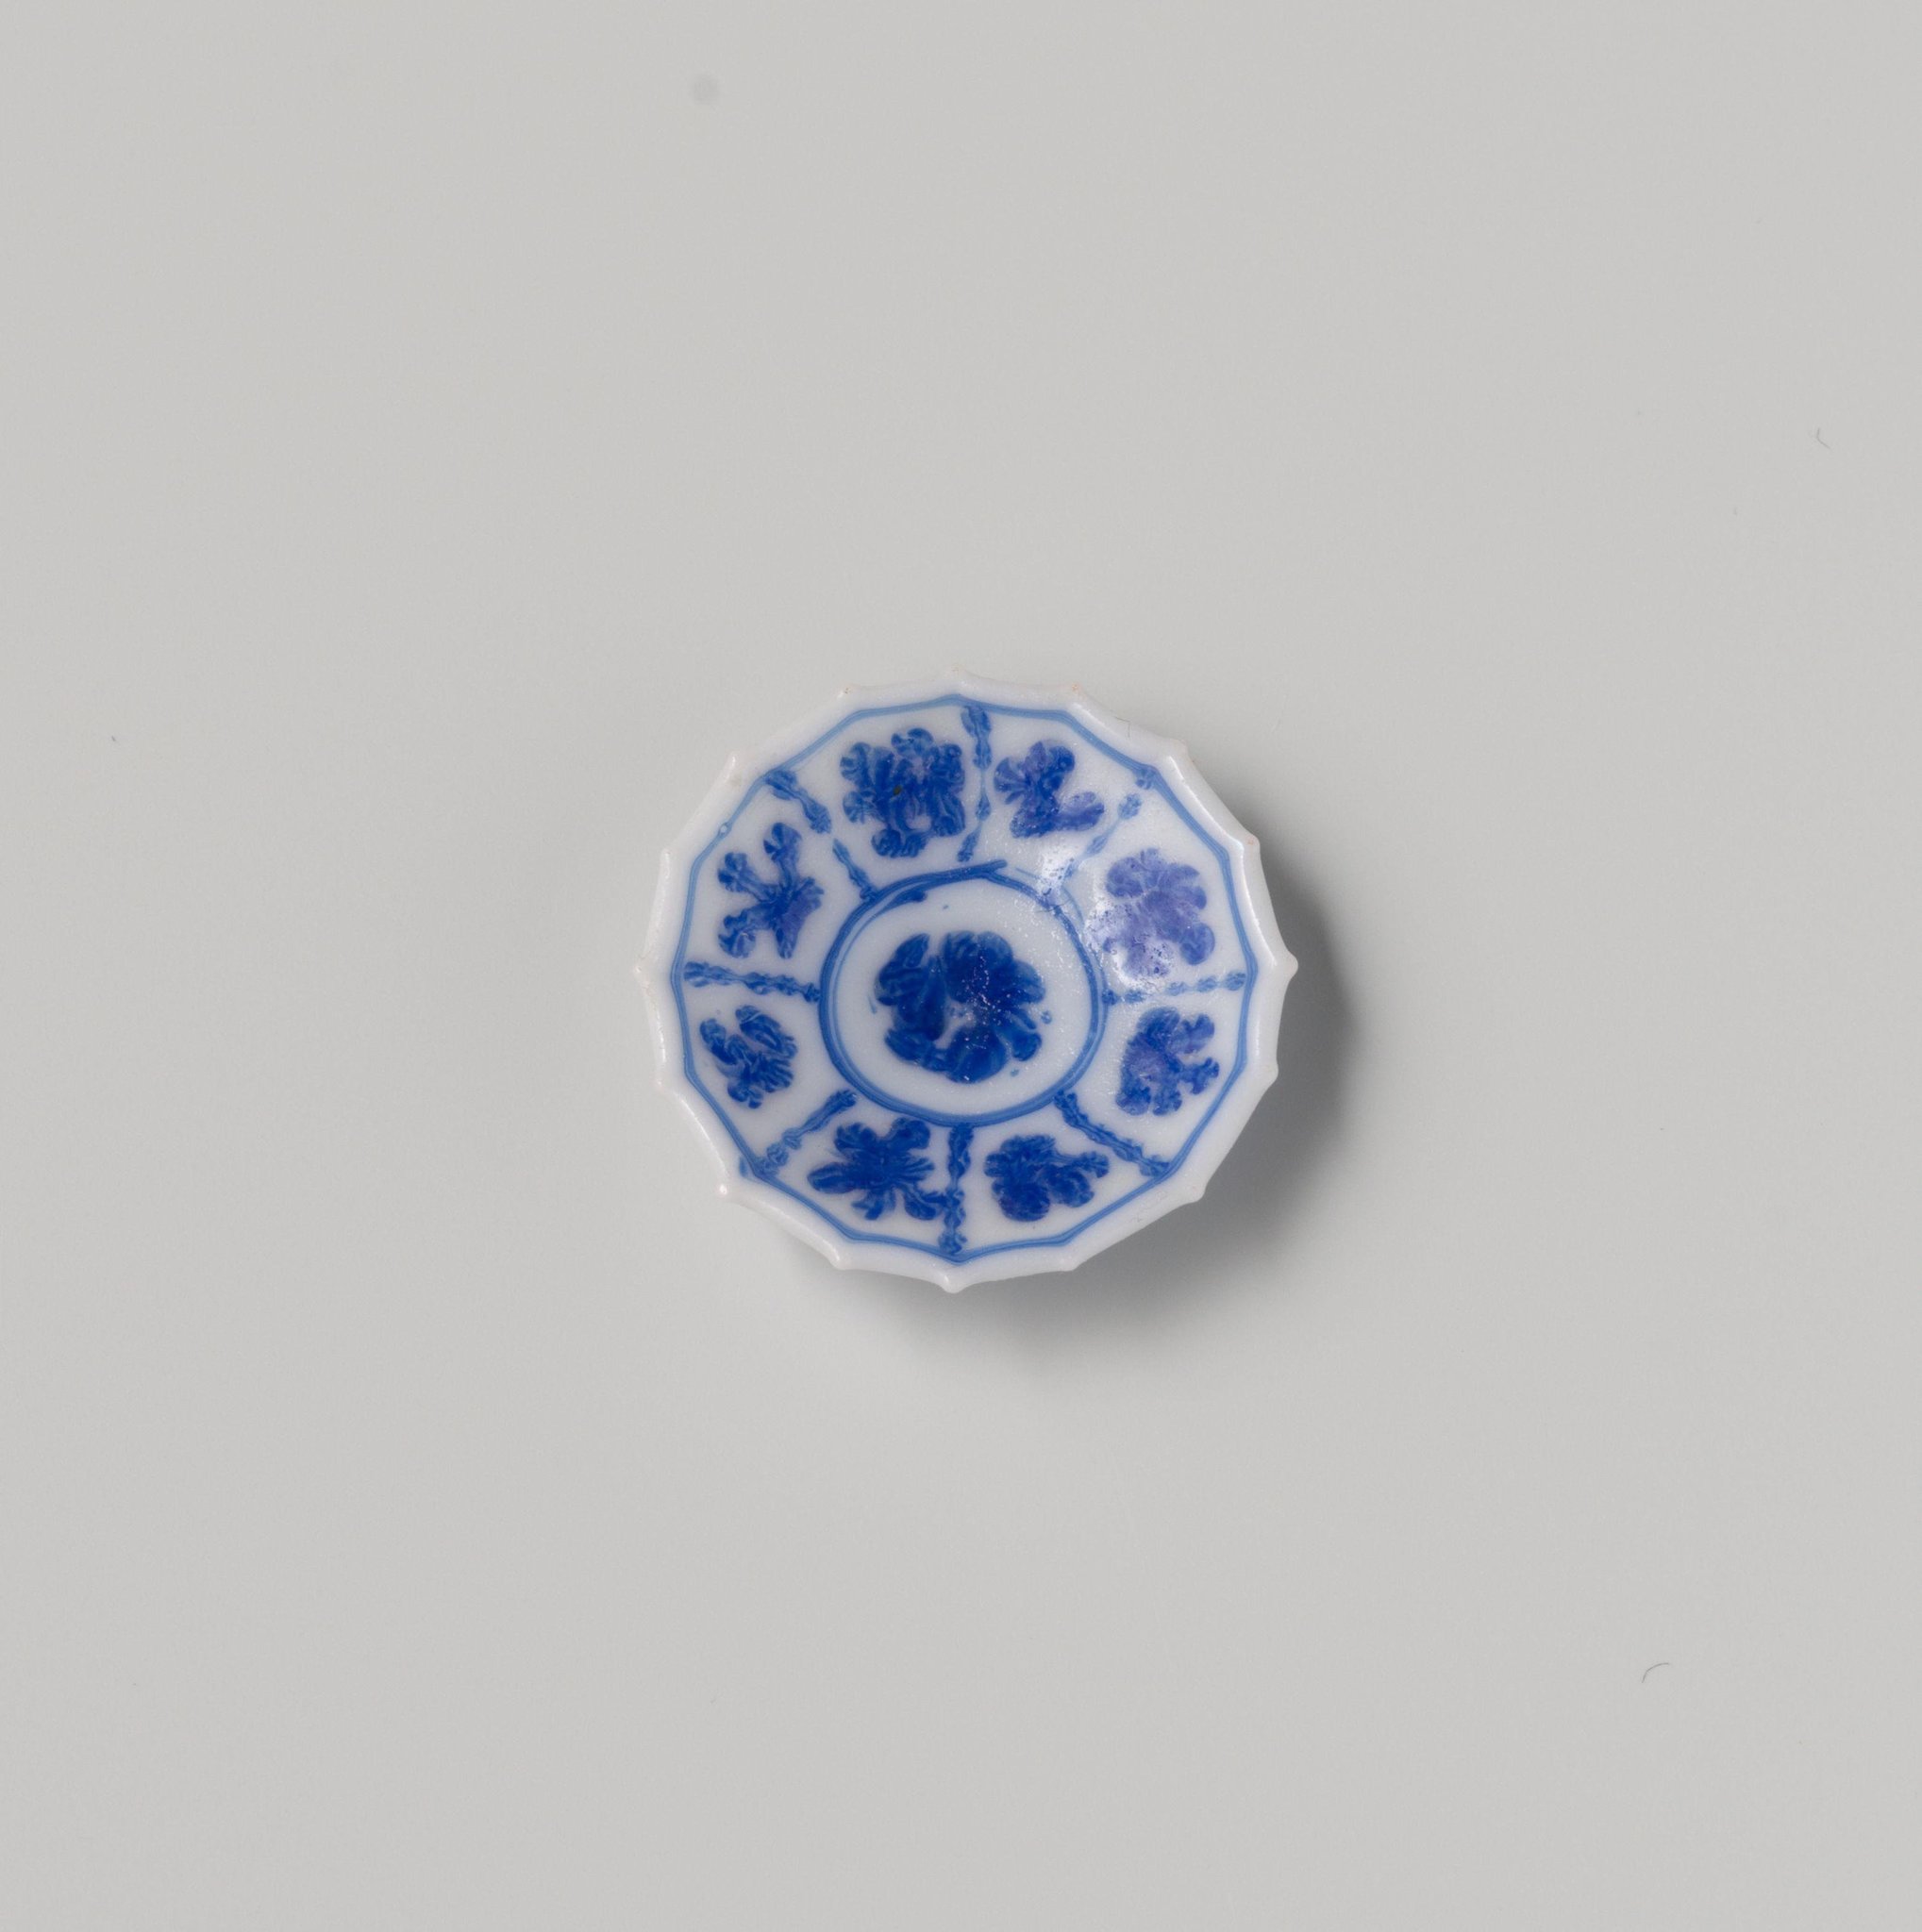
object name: plate dish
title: Schotel van melkglas met blauwe emailverf beschildering, imitatie Chinees porselein; bloemmotieven in vakken in Kraakporselein stijl; dubbelwandig, de rand in punten geknepen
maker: Anonymous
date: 1675-1710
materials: glass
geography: amsterdam